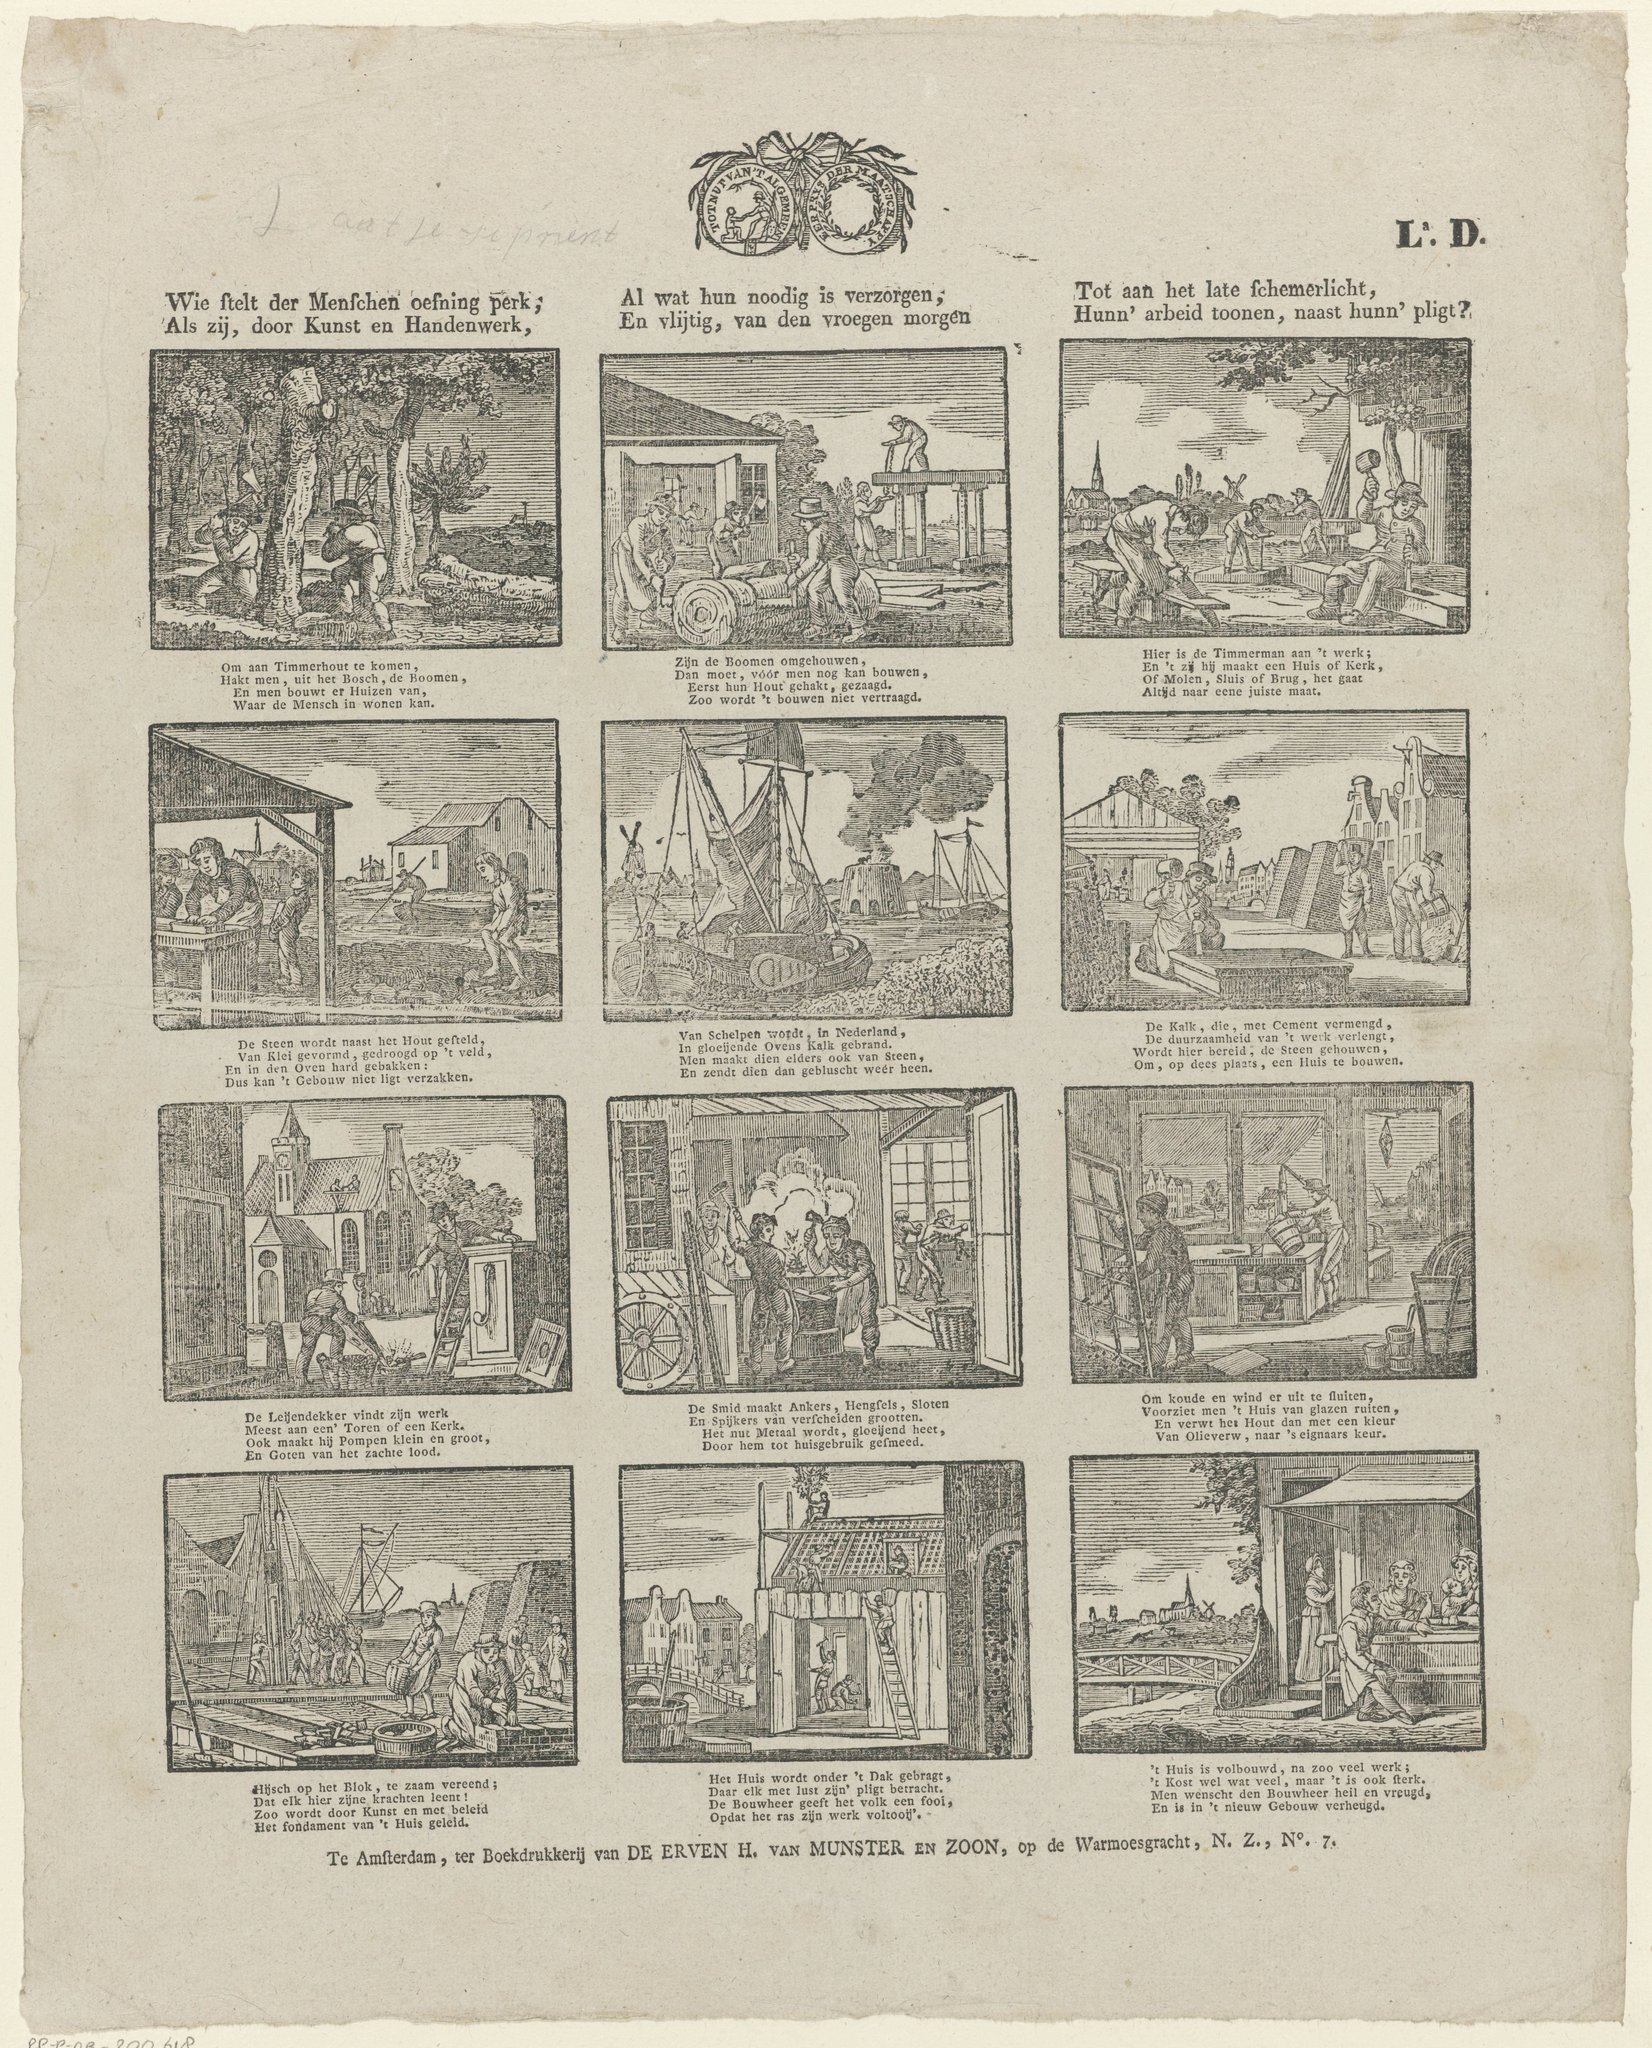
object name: popular print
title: Prenten uitgegeven door de maatschappij: / Tot nut van 't algemeen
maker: alexander cranendoncq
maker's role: draughtsman, print maker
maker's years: 1799-1869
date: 1829-1856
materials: paper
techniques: letterpress printing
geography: amsterdam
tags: carpenter, roof (of house or building), industries ~ clay, sand, chalk, etc., housing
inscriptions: collector's mark: Lugt 2760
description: Blad met 12 voorstellingen van stappen in het bouwen van een huis, van hout verzamelen en cement maken tot een dak op het huis zetten. Onder elke afbeelding een vierregelig vers. Midden boven het zegel van de Maatschappij tot Nut van 't Algemeen. Gemerkt rechtsboven: L. D.